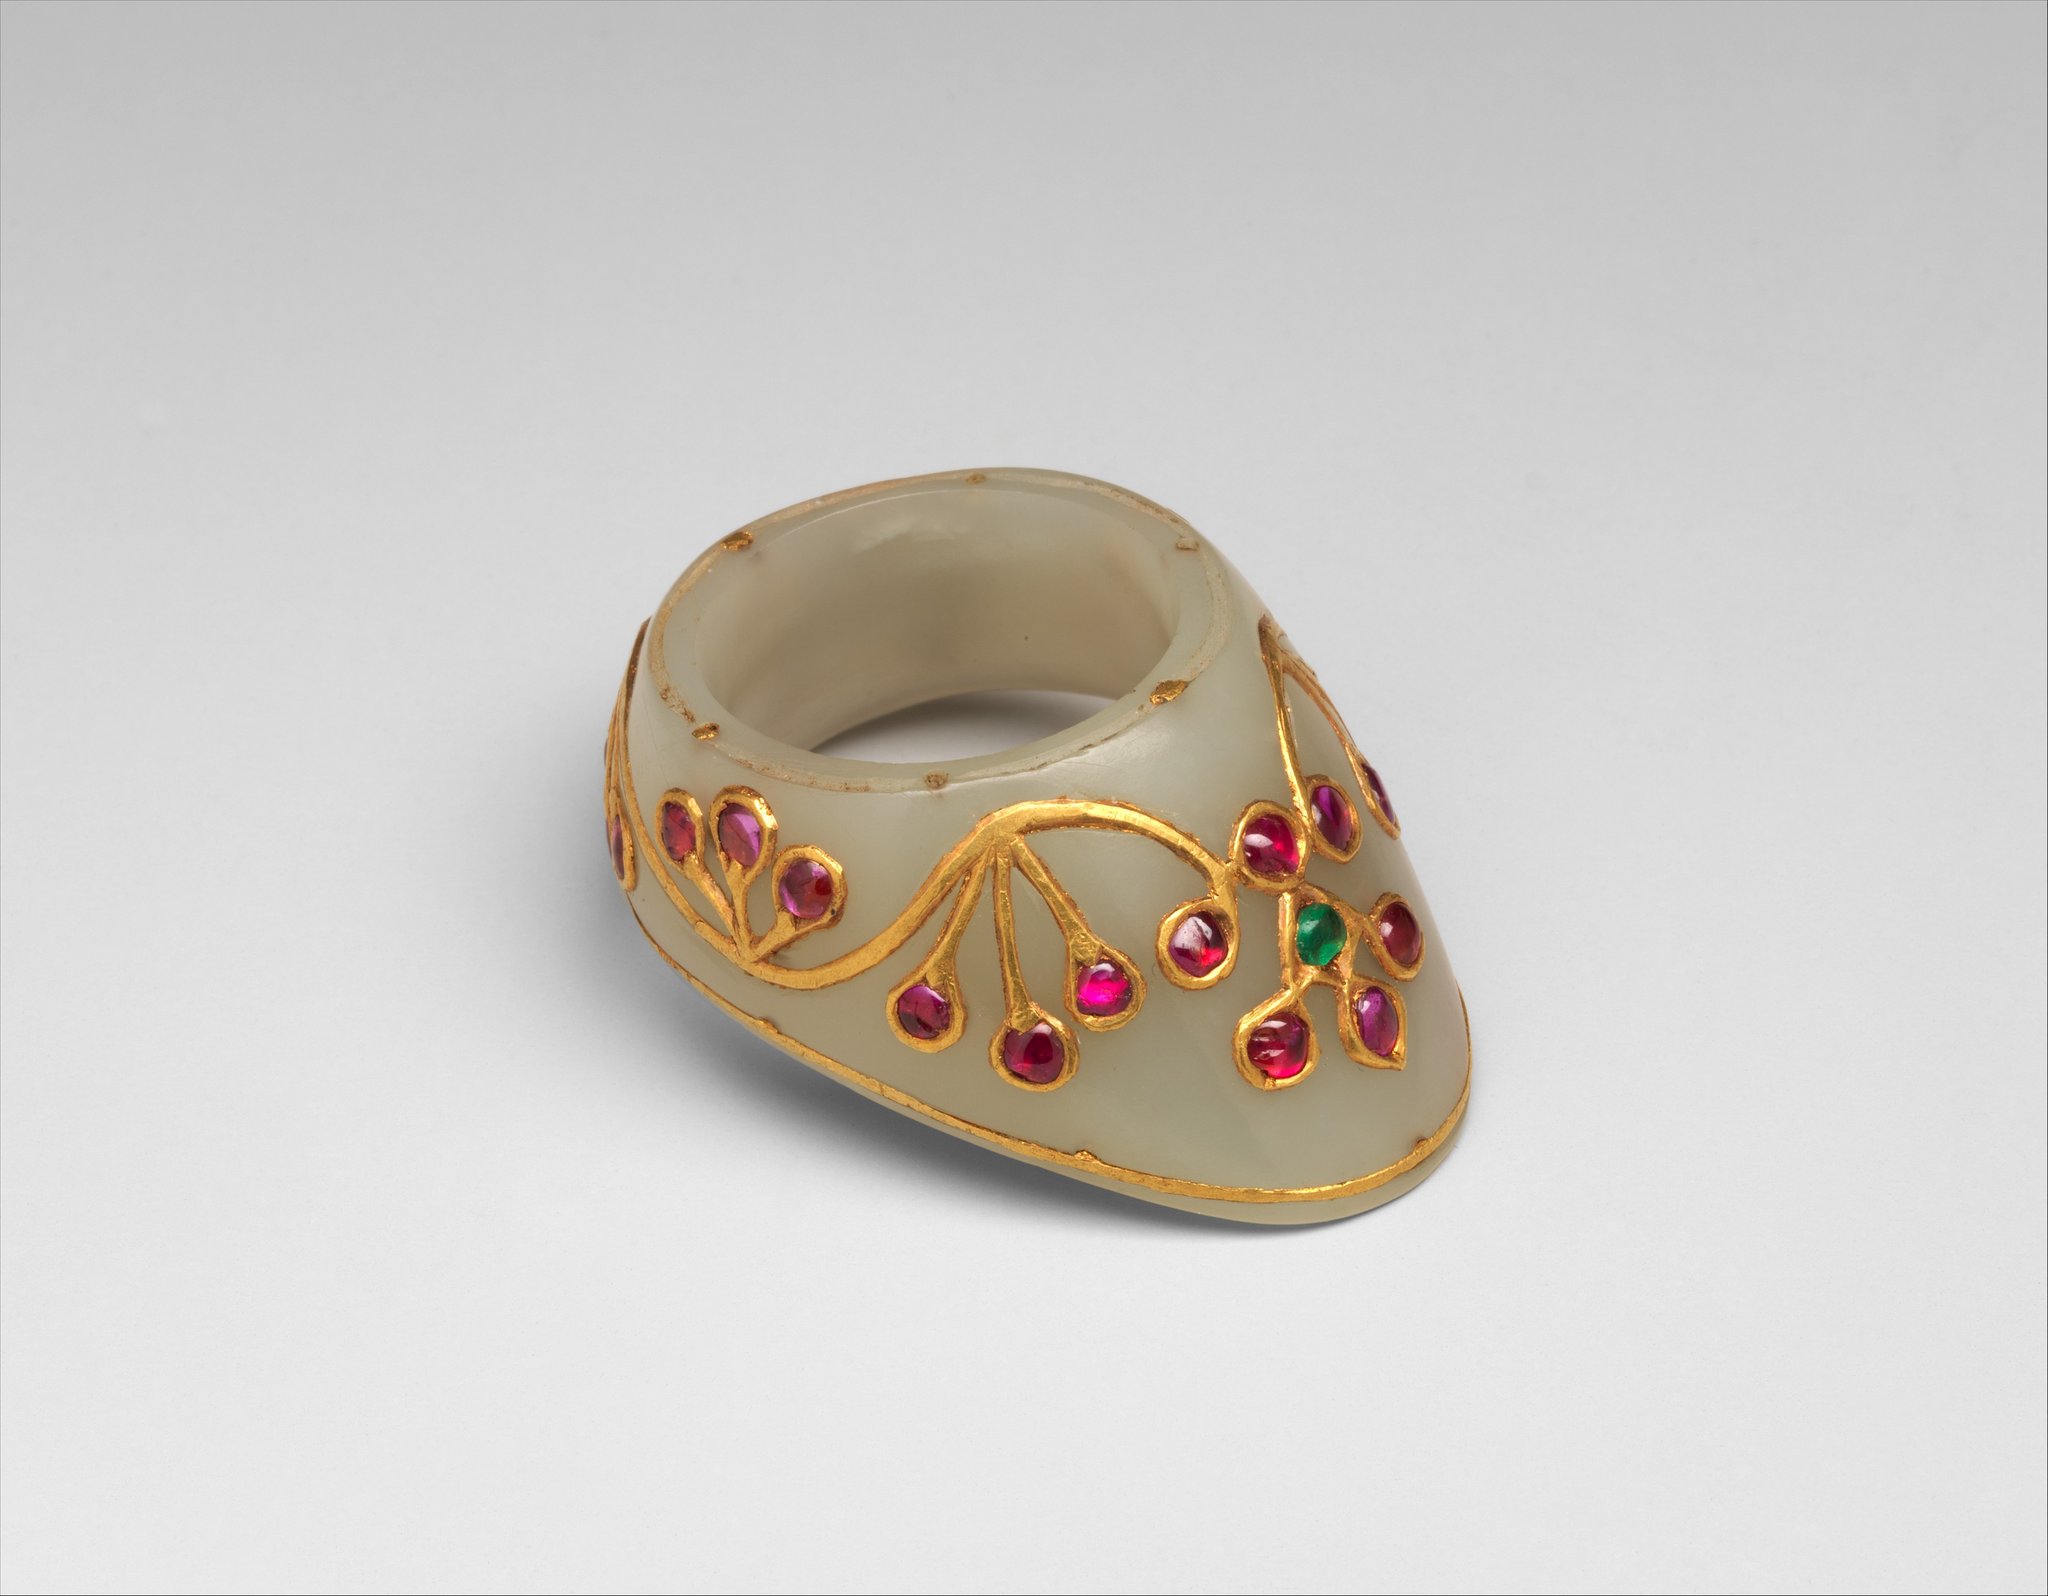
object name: archer's ring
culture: indian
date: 1801-1900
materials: gemstone, gold, jade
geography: india